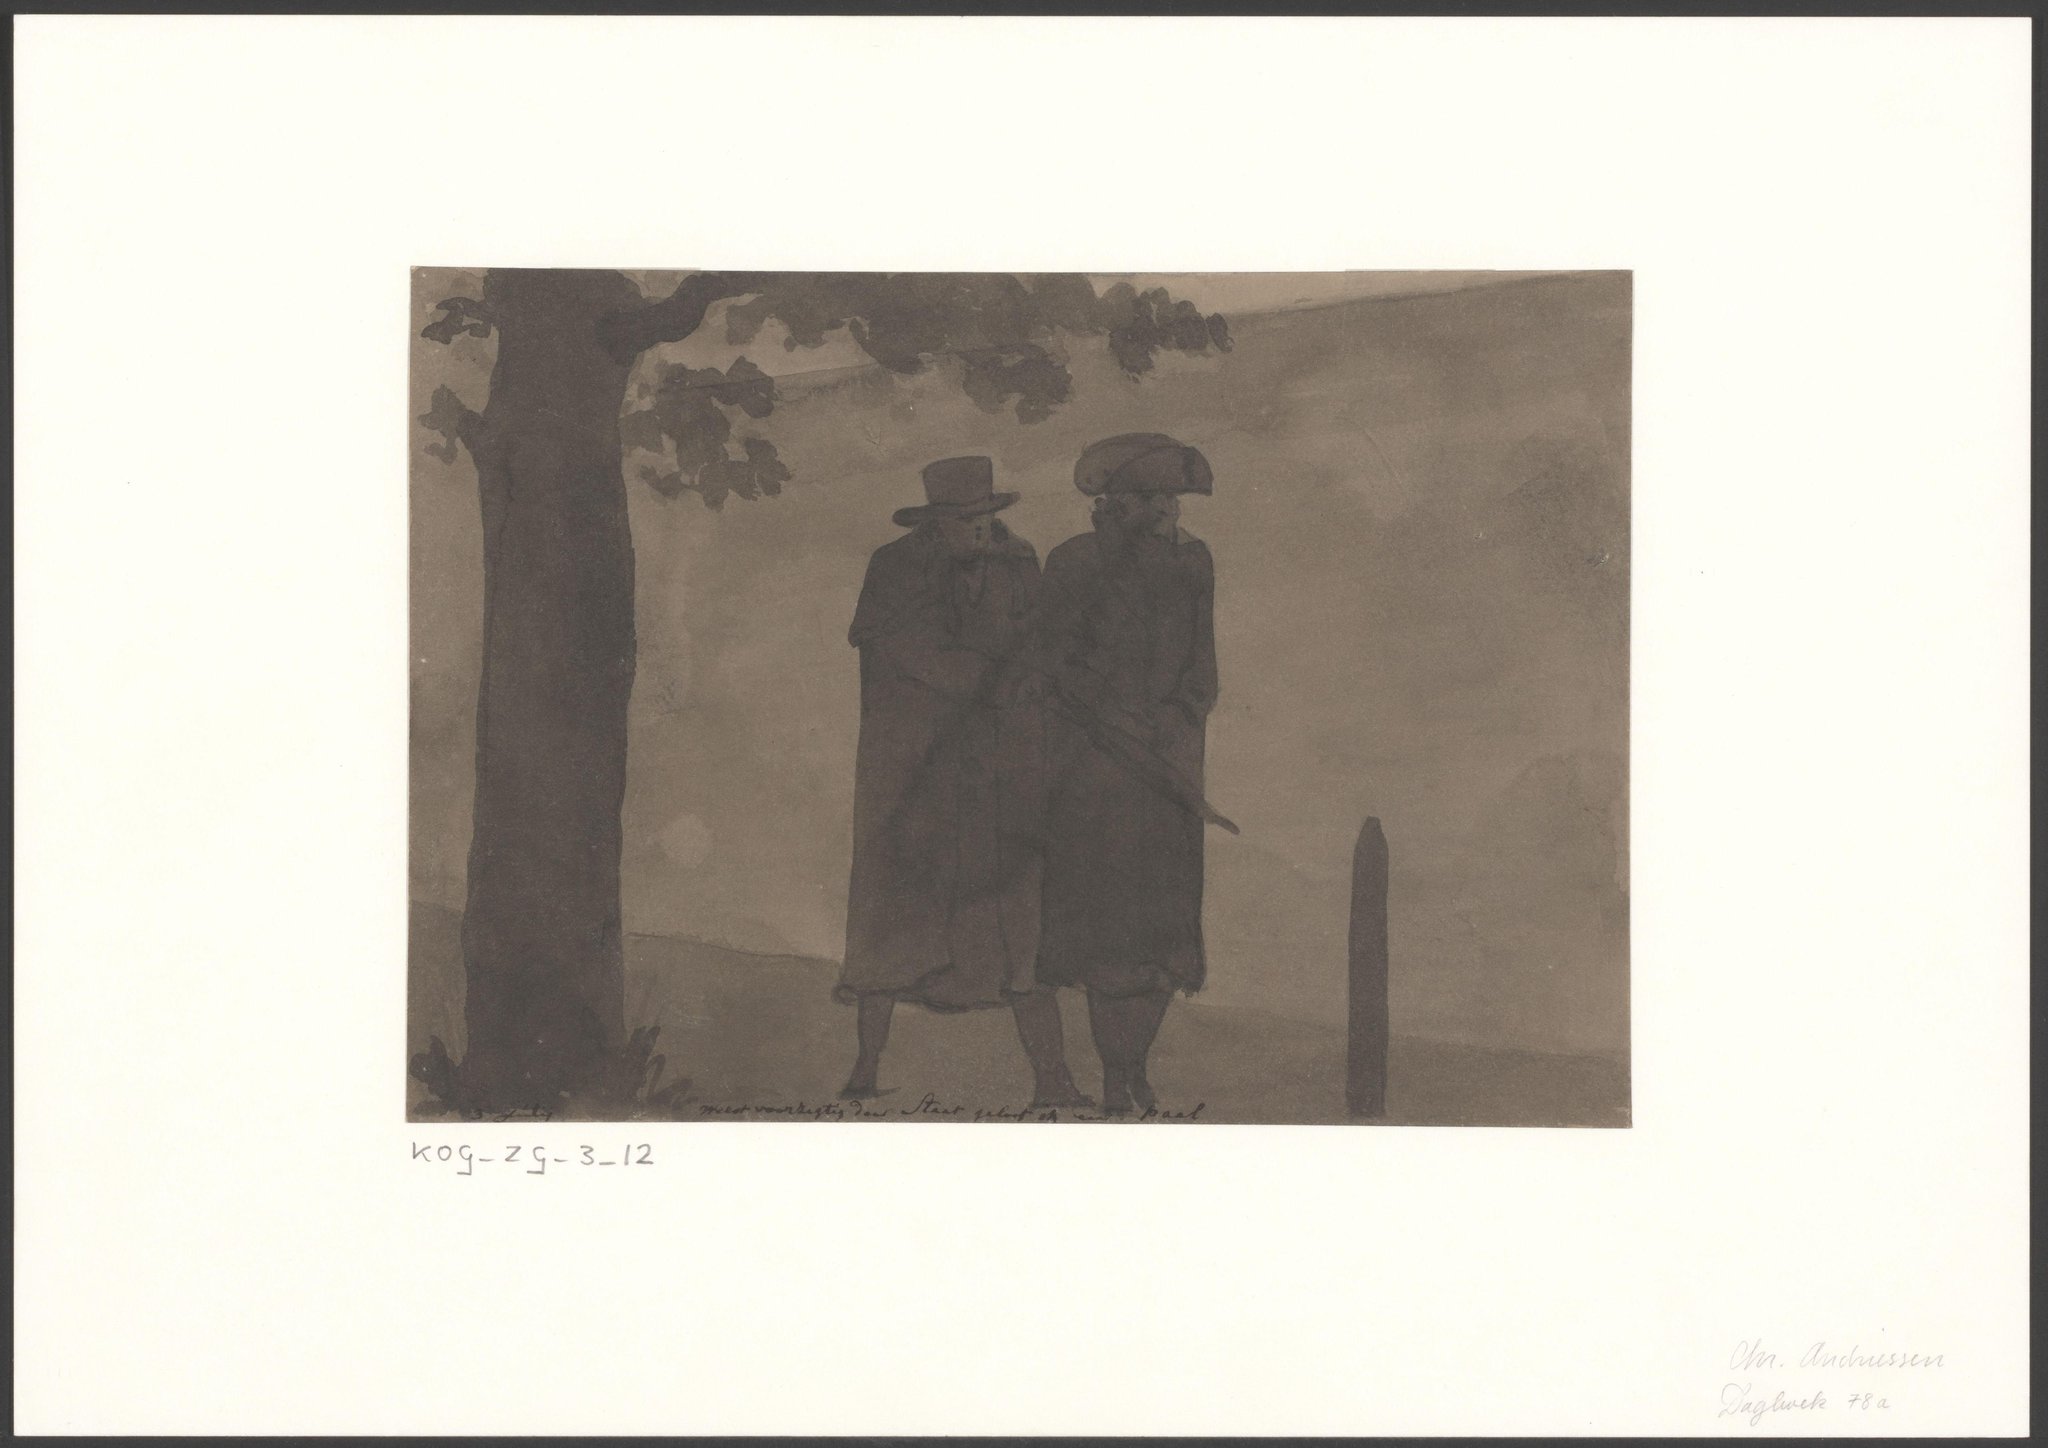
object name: drawing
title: Twee mannen wandelen voorzichtig op een mistige avond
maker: christiaan andriessen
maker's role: draughtsman, print maker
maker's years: 1775-1846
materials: ink, paper, pencil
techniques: brush, pen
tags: public gardens, park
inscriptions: inscription: ‘3 julij wees voorzichtig daar staat geloof ik een paal’, inscription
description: Dagboekblad uit het getekende dagboek dat Christiaan Andriessen bijhield van 1805 tot en met 1808.